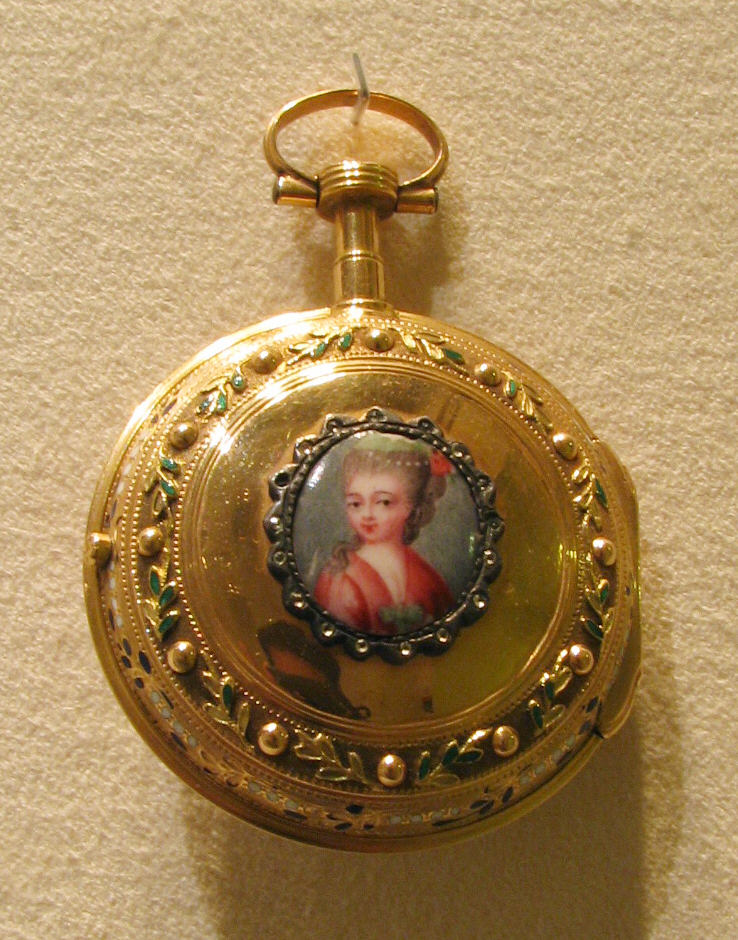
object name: watch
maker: jean antoine lépine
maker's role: maker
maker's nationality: french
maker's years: 1720-1814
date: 1766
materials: diamond, enamel, gold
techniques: enamel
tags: portraits,women